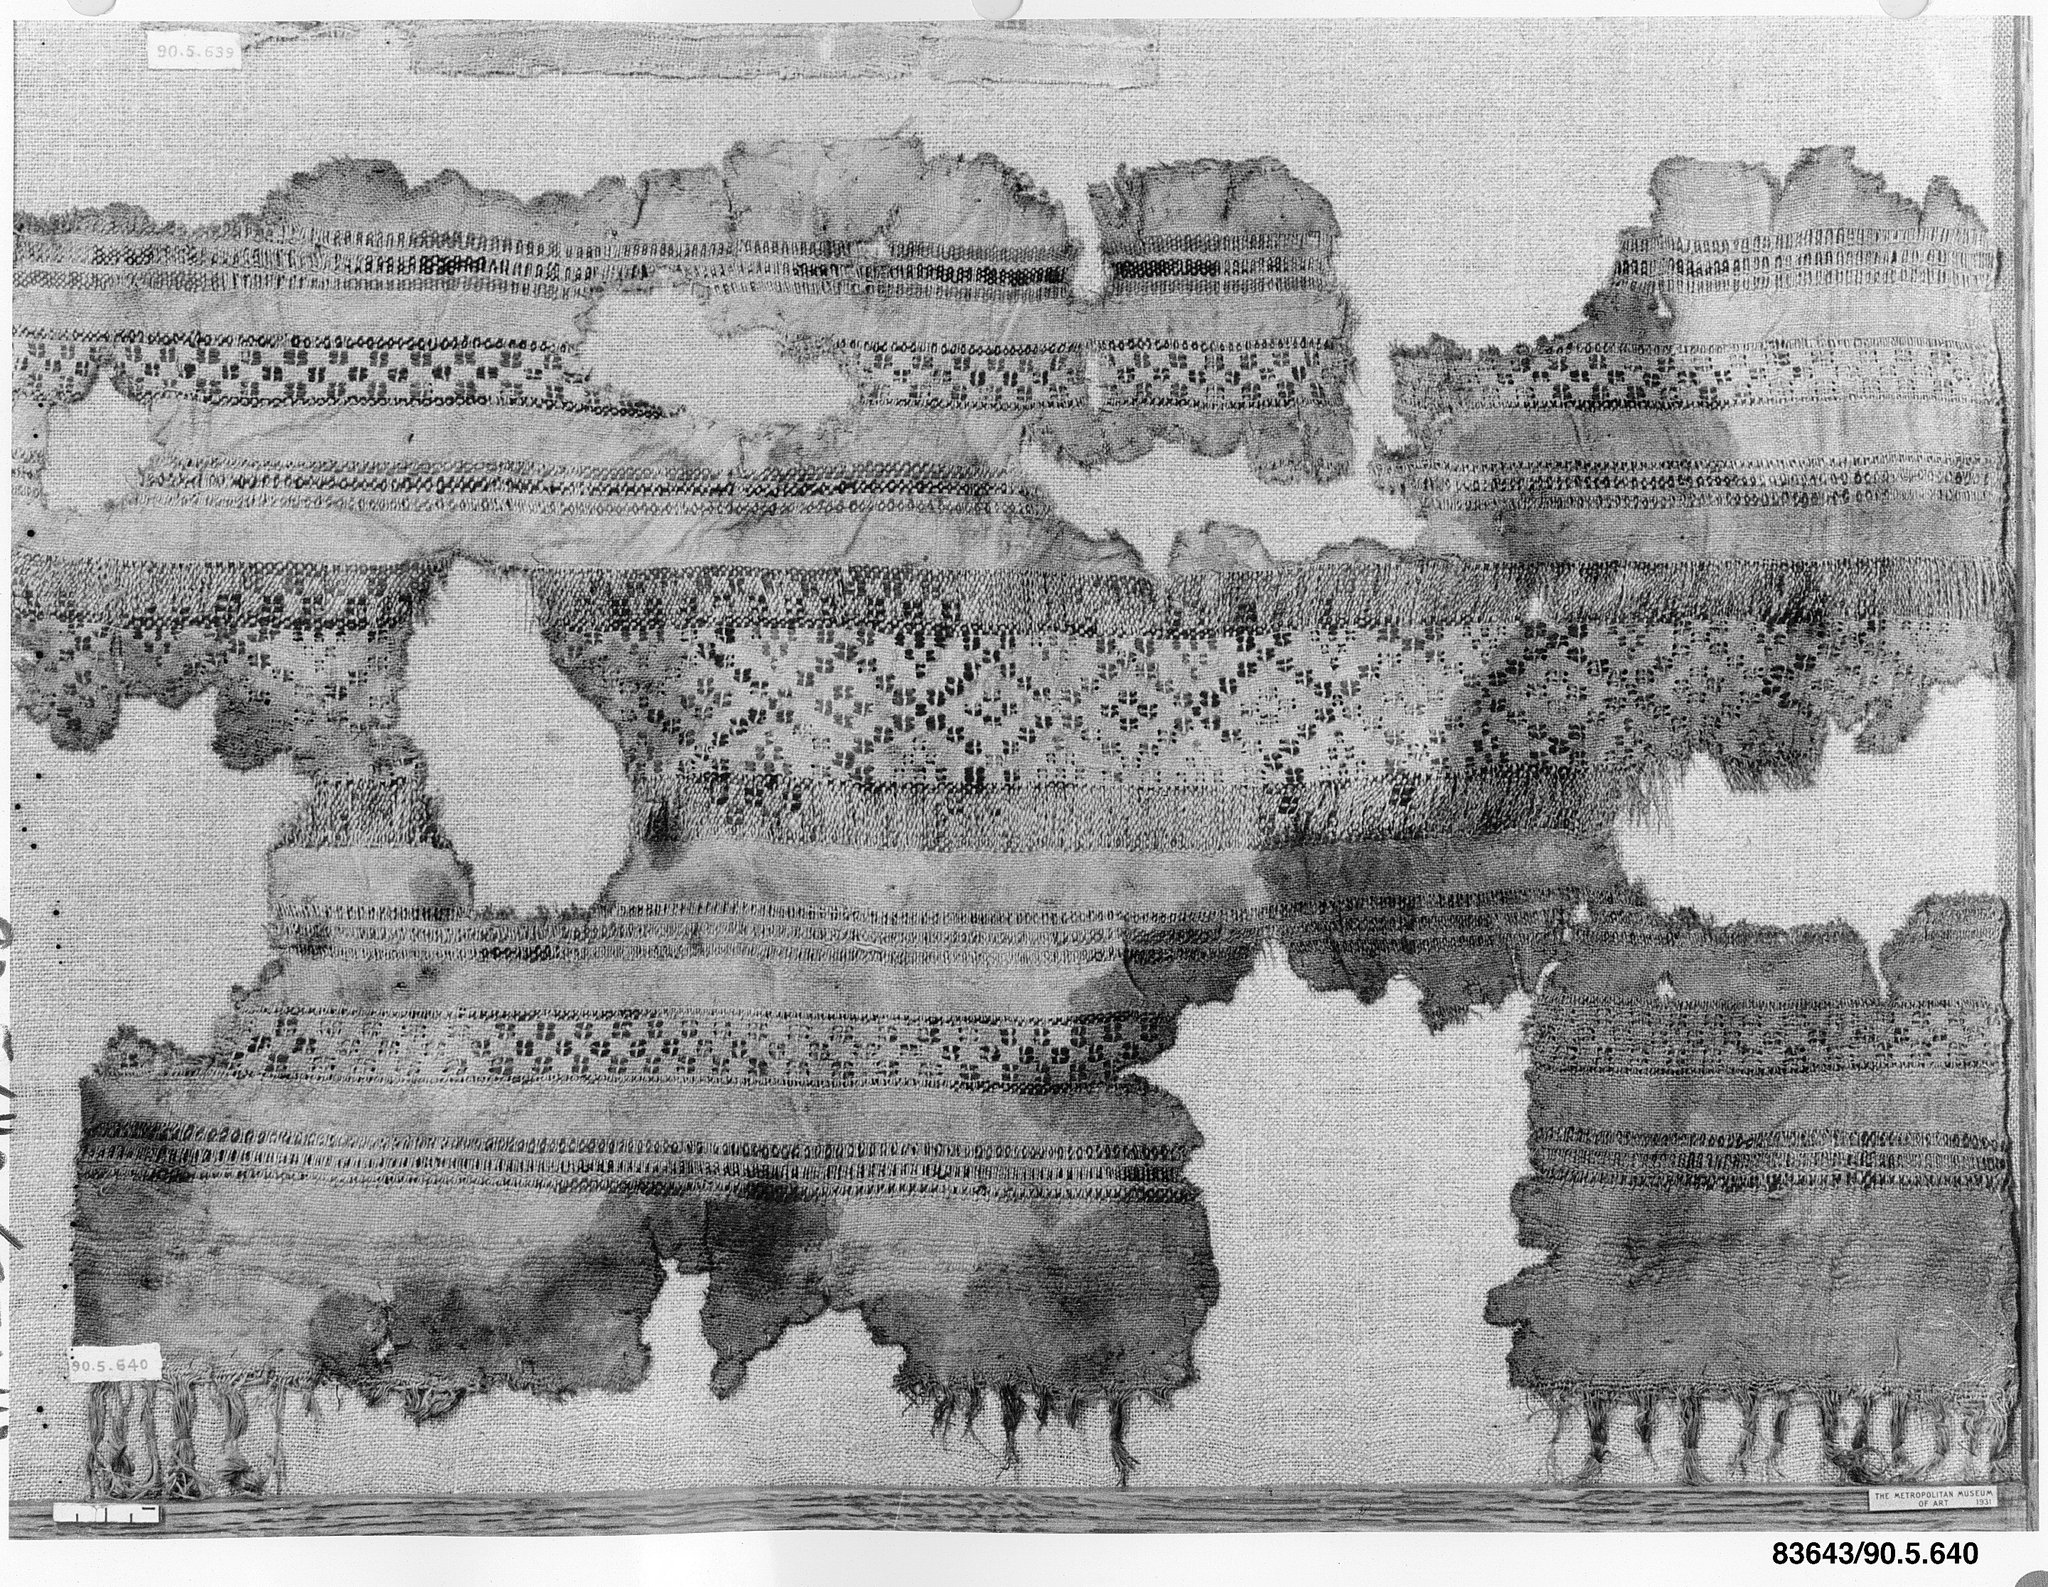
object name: textile fragment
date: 301-500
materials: linen, wool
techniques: brocade, weave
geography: egypt